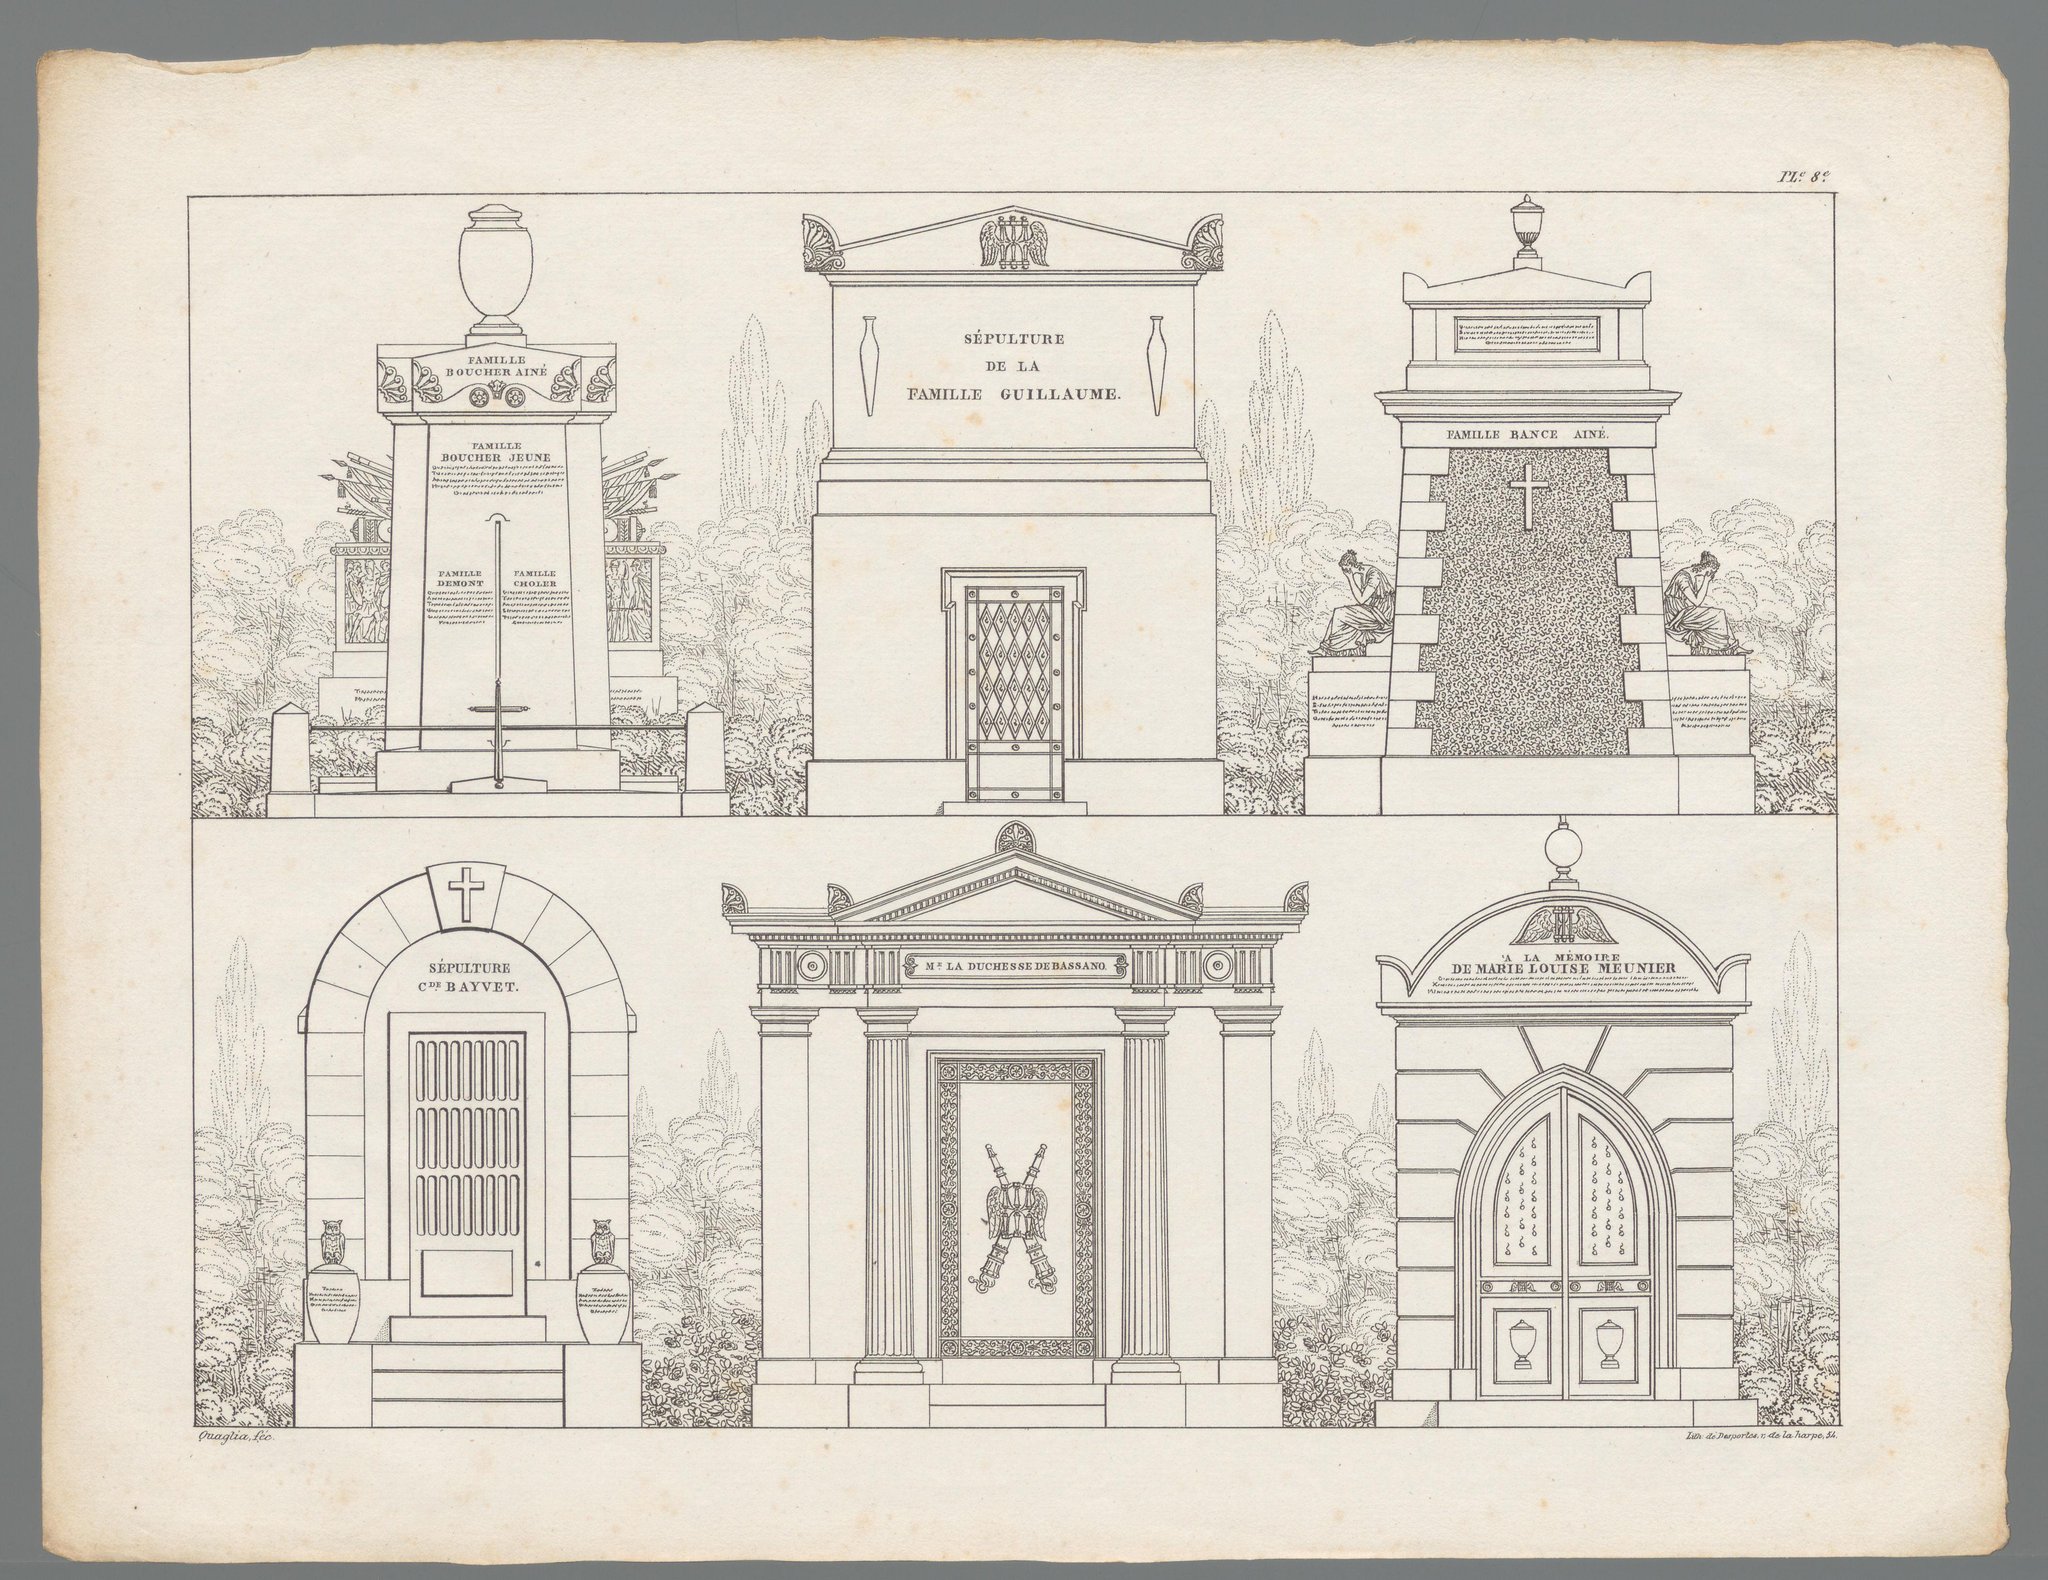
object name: print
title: Gezichten op het Cimetière du Père-Lachaise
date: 1803-1869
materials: paper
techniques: lithograph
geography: paris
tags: cemetery, park-like burying ground